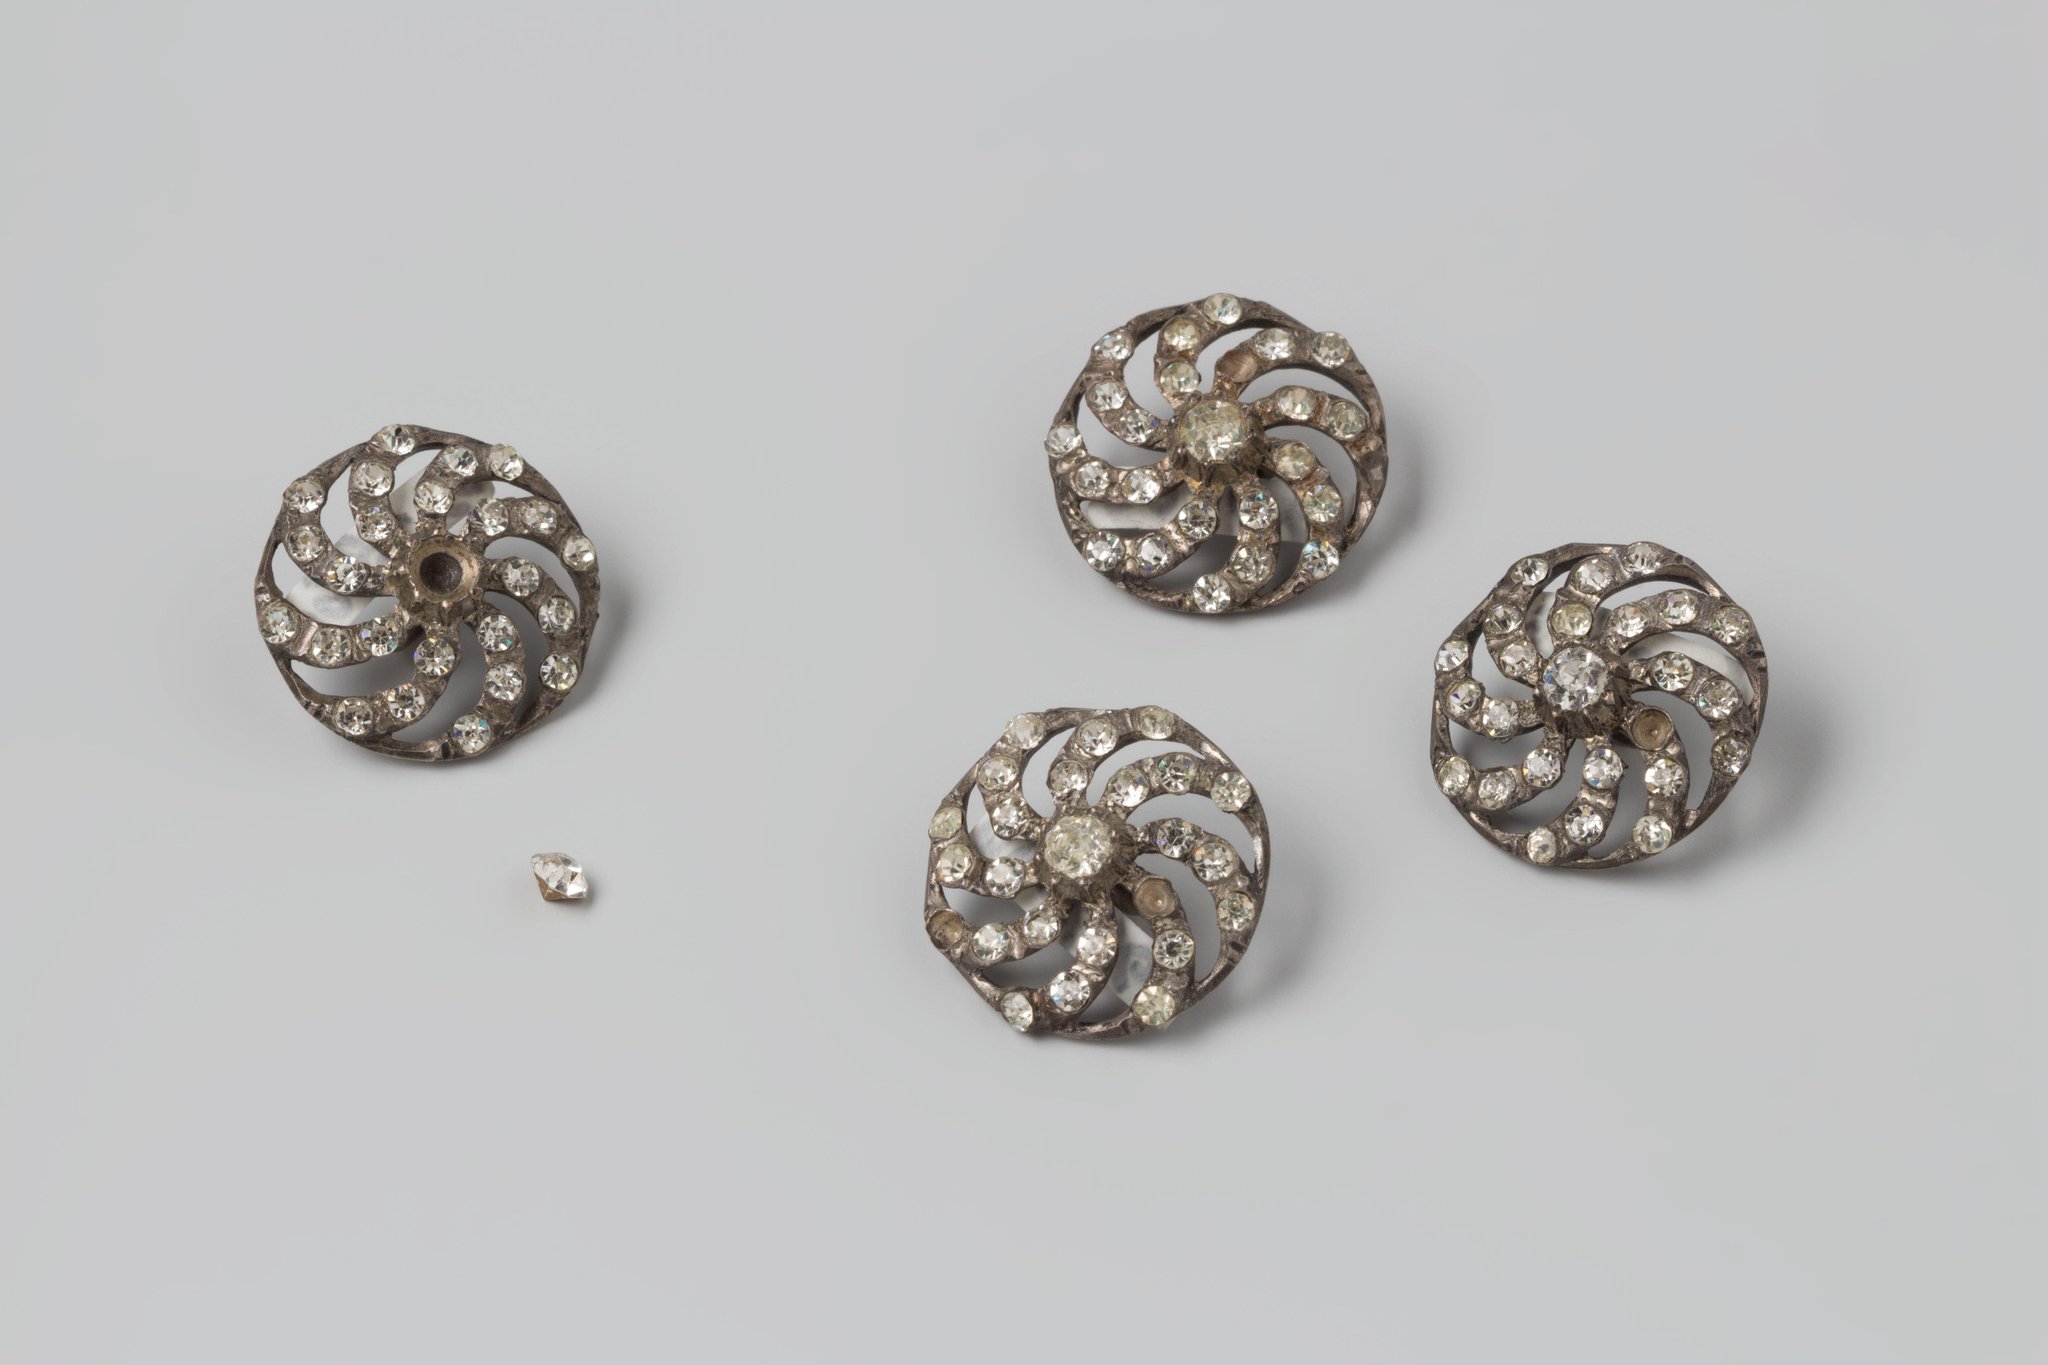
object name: button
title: Knoop met in het midden een grote steen waaromheen acht kleine op gebogen spaken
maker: Anonymous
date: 1800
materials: paste, silver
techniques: forging, grinding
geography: france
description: Vier knopen van zilver en strasz. Versierd met acht gebogen spaken met kleine strassteentjes, vanuit 1 grote steen in het midden.